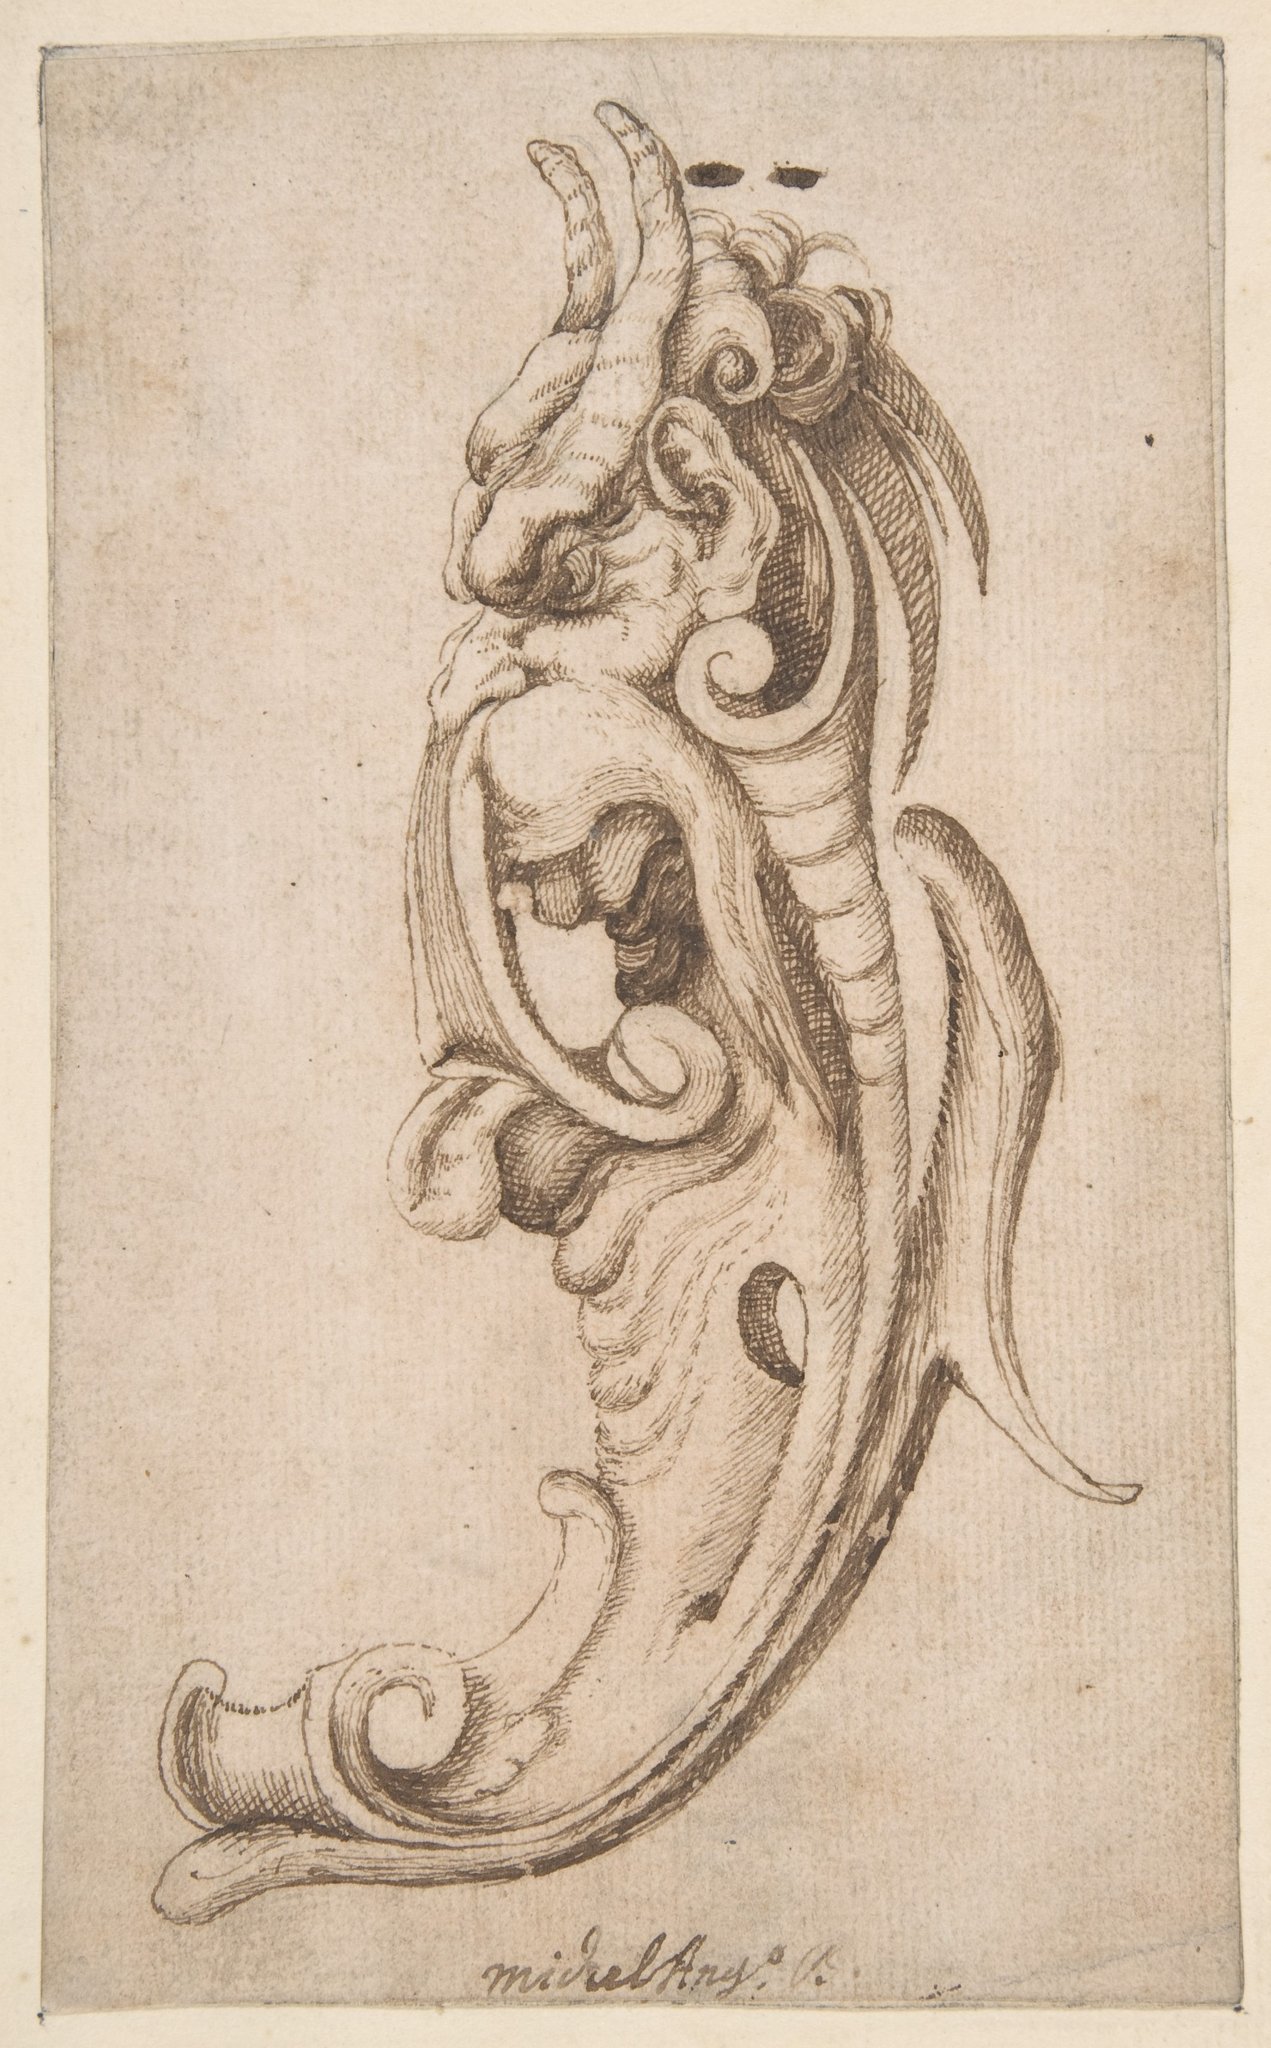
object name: drawing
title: Cartouche in the Form of a Horned Monster's Head in Near Profile View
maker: michelangelo colonna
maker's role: artist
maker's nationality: italian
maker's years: 1604-1687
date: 1604-1687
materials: graphite, ink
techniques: pen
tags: cartouches,monsters